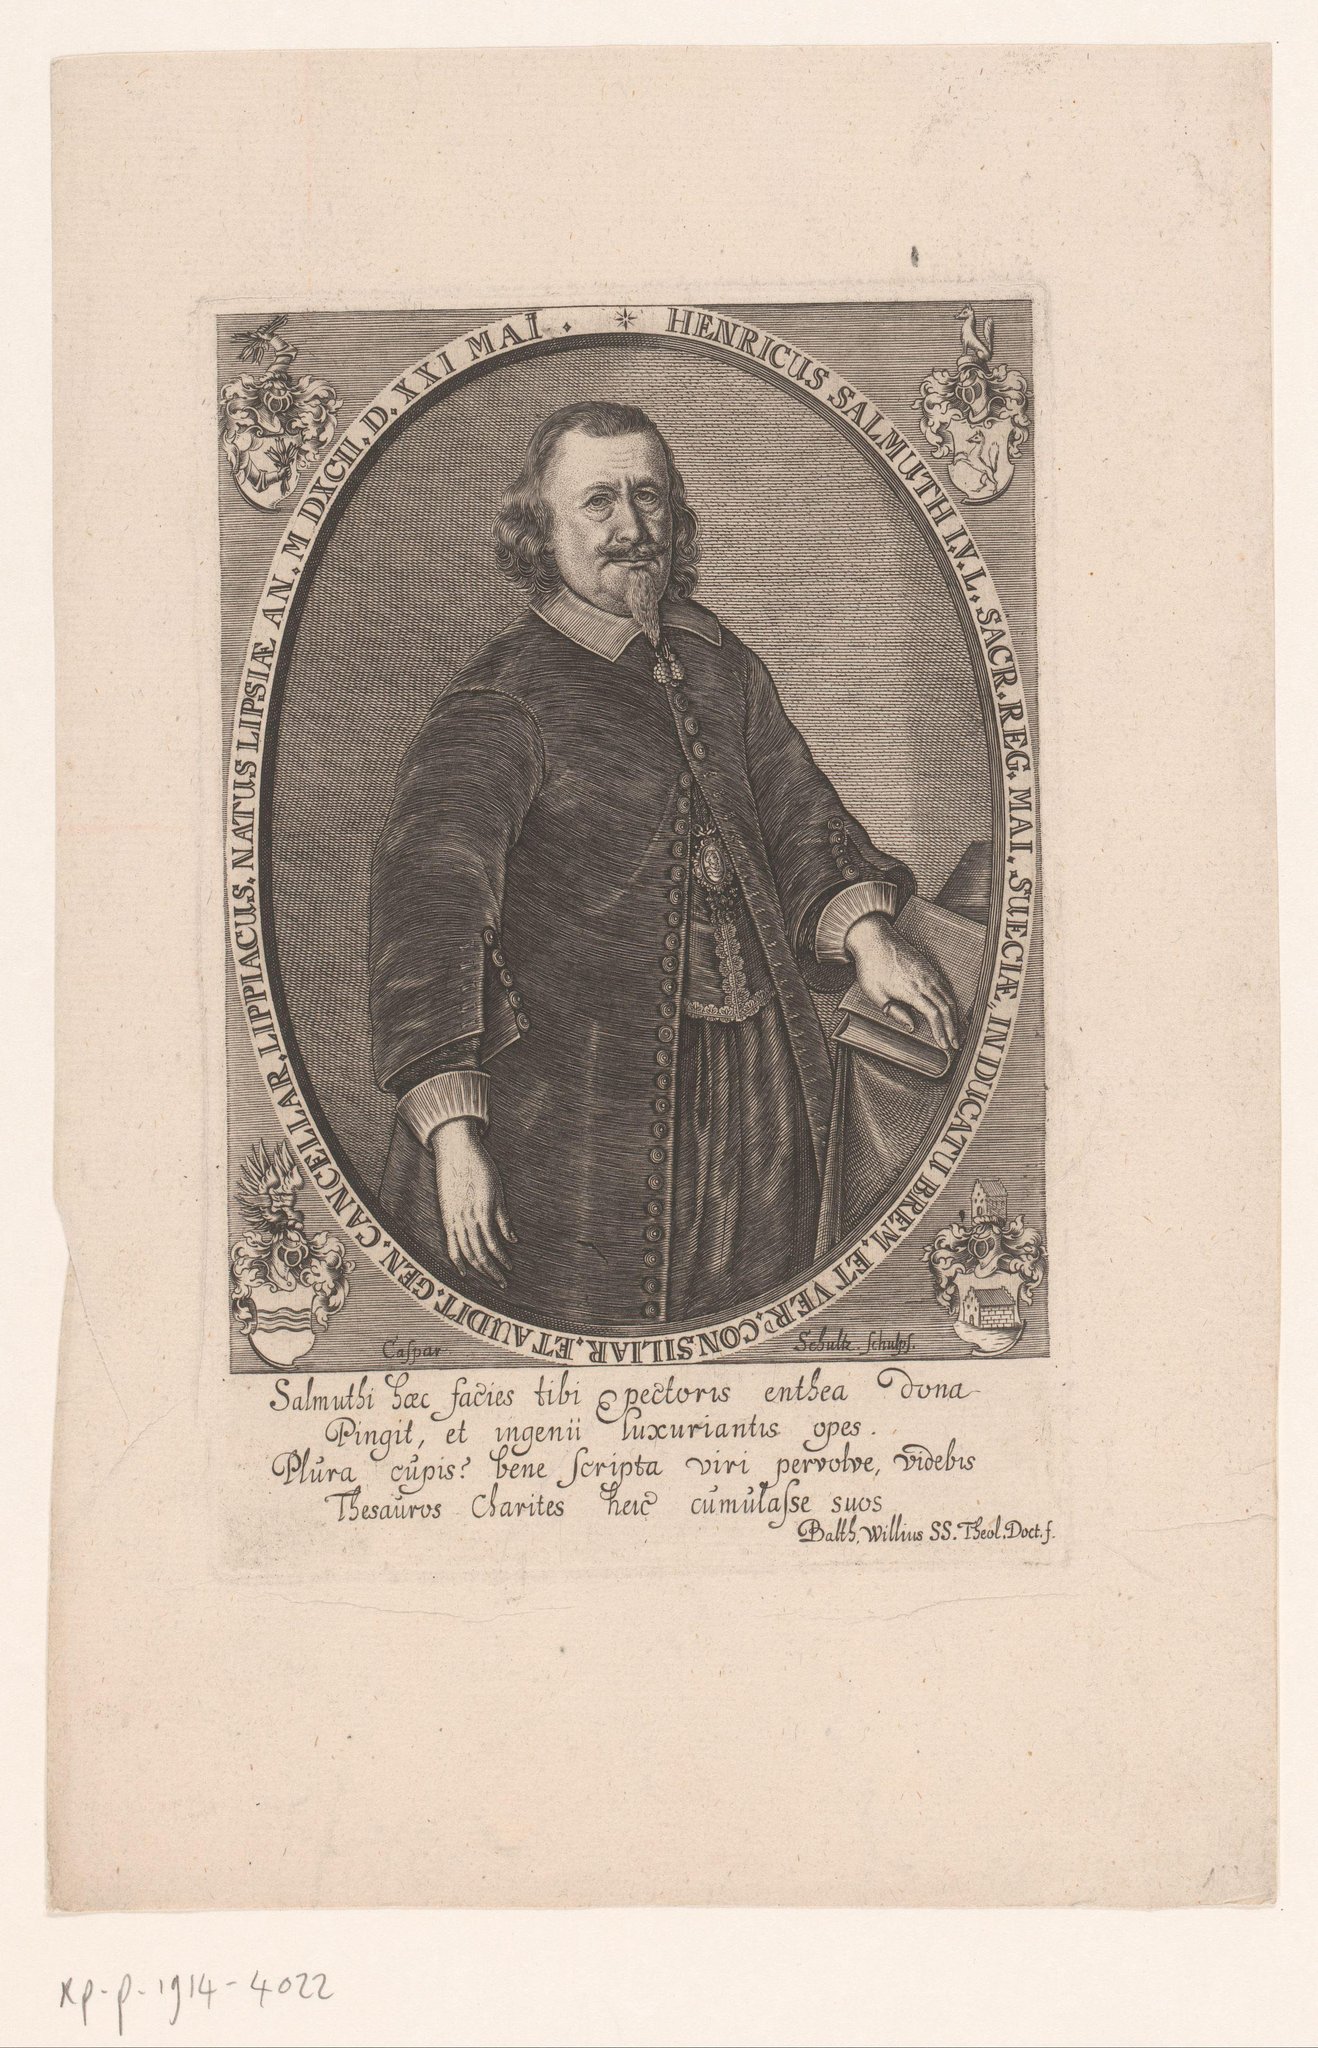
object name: print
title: Portret van Heinrich Salmuth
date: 1600-1699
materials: paper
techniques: engraving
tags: theologian, historical persons, armorial bearing, heraldry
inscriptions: collector's mark: Lugt 2228